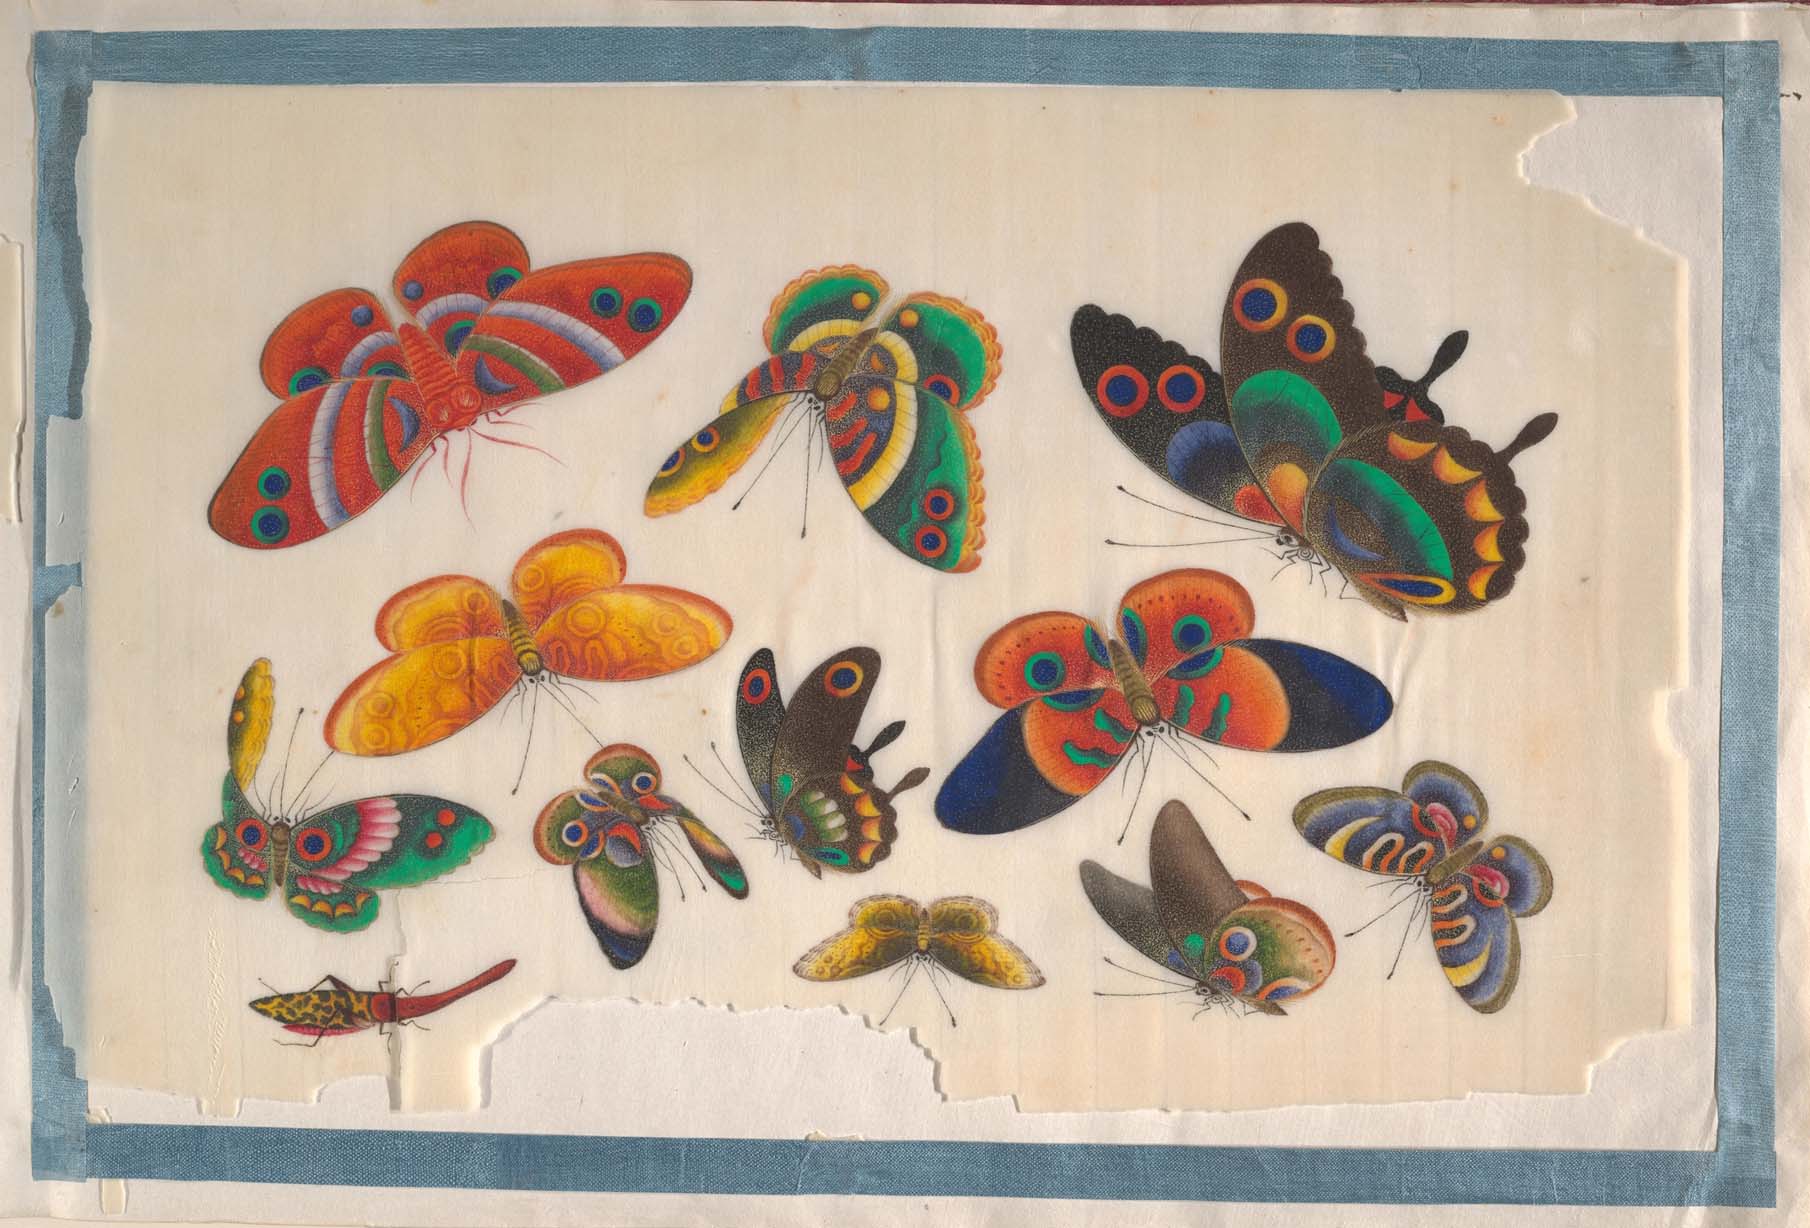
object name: album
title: Album Containing Twelve Paintings of Insects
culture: chinese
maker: unidentified artist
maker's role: artist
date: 1801-1900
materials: paper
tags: insects,butterflies